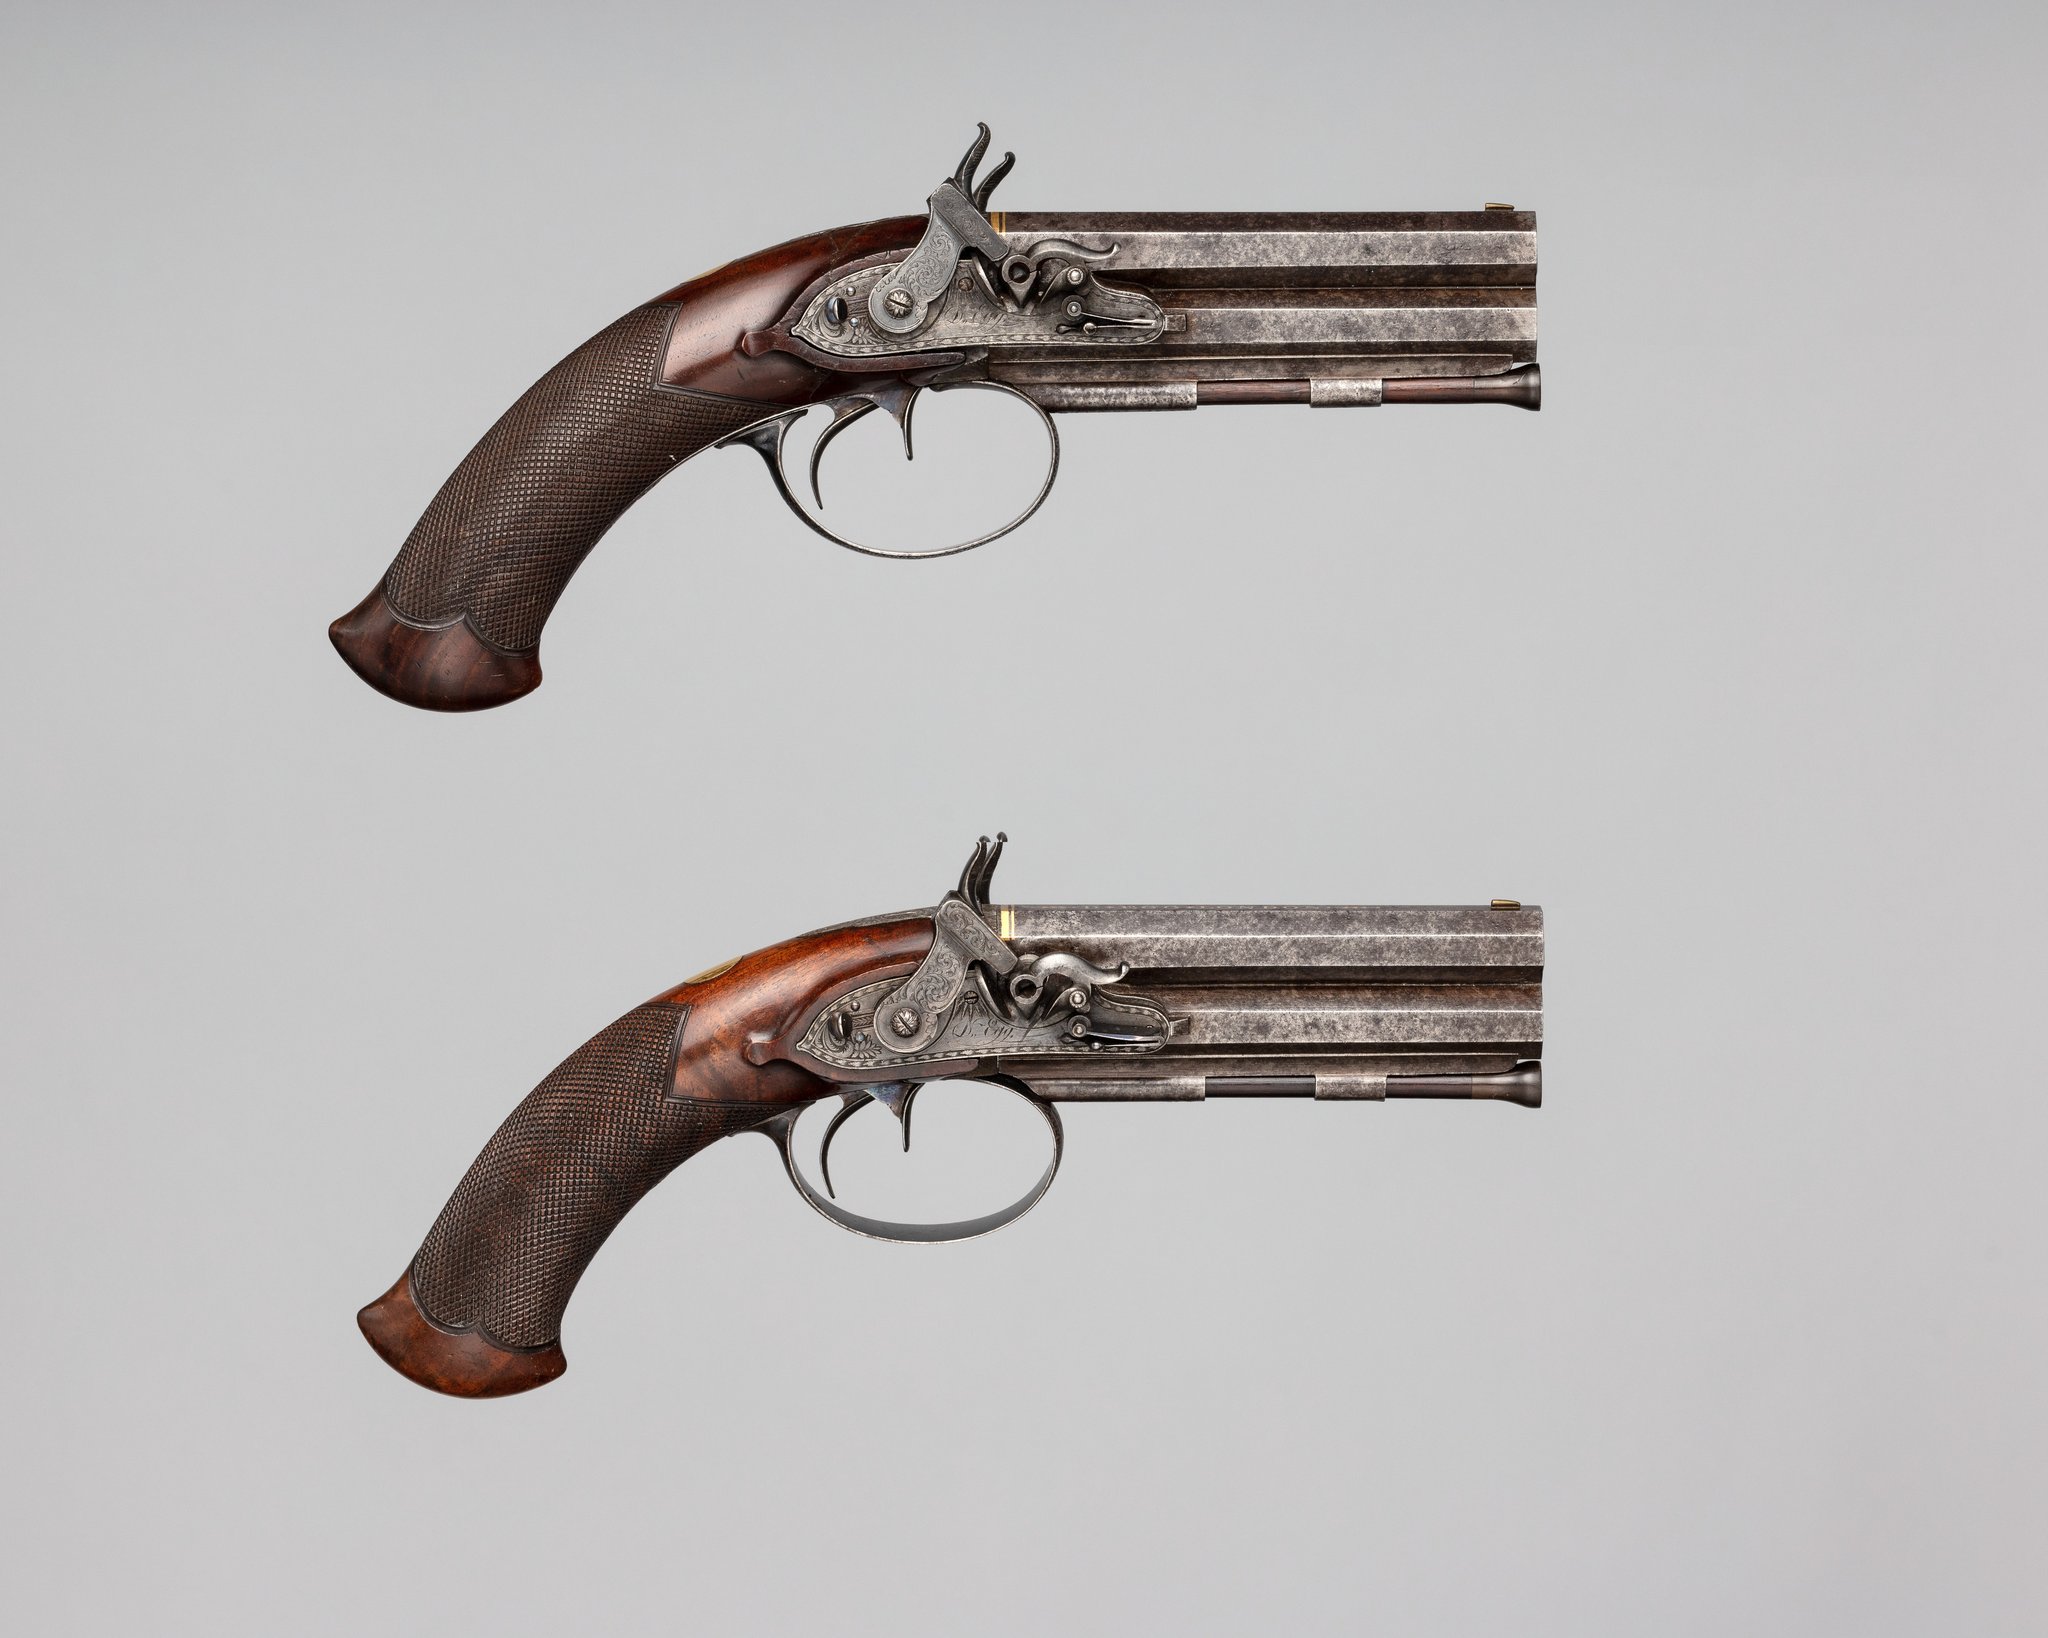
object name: cased pair of percussion pistol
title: Pair of Over-and-Under Tube-Lock Percussion Pistols with Case and Accessories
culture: british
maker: durs egg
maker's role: gunsmith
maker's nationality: swiss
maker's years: 1748-1831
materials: bone, brass, gold, horn, leather, paper, platinum, steel, textile, tin, wood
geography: england